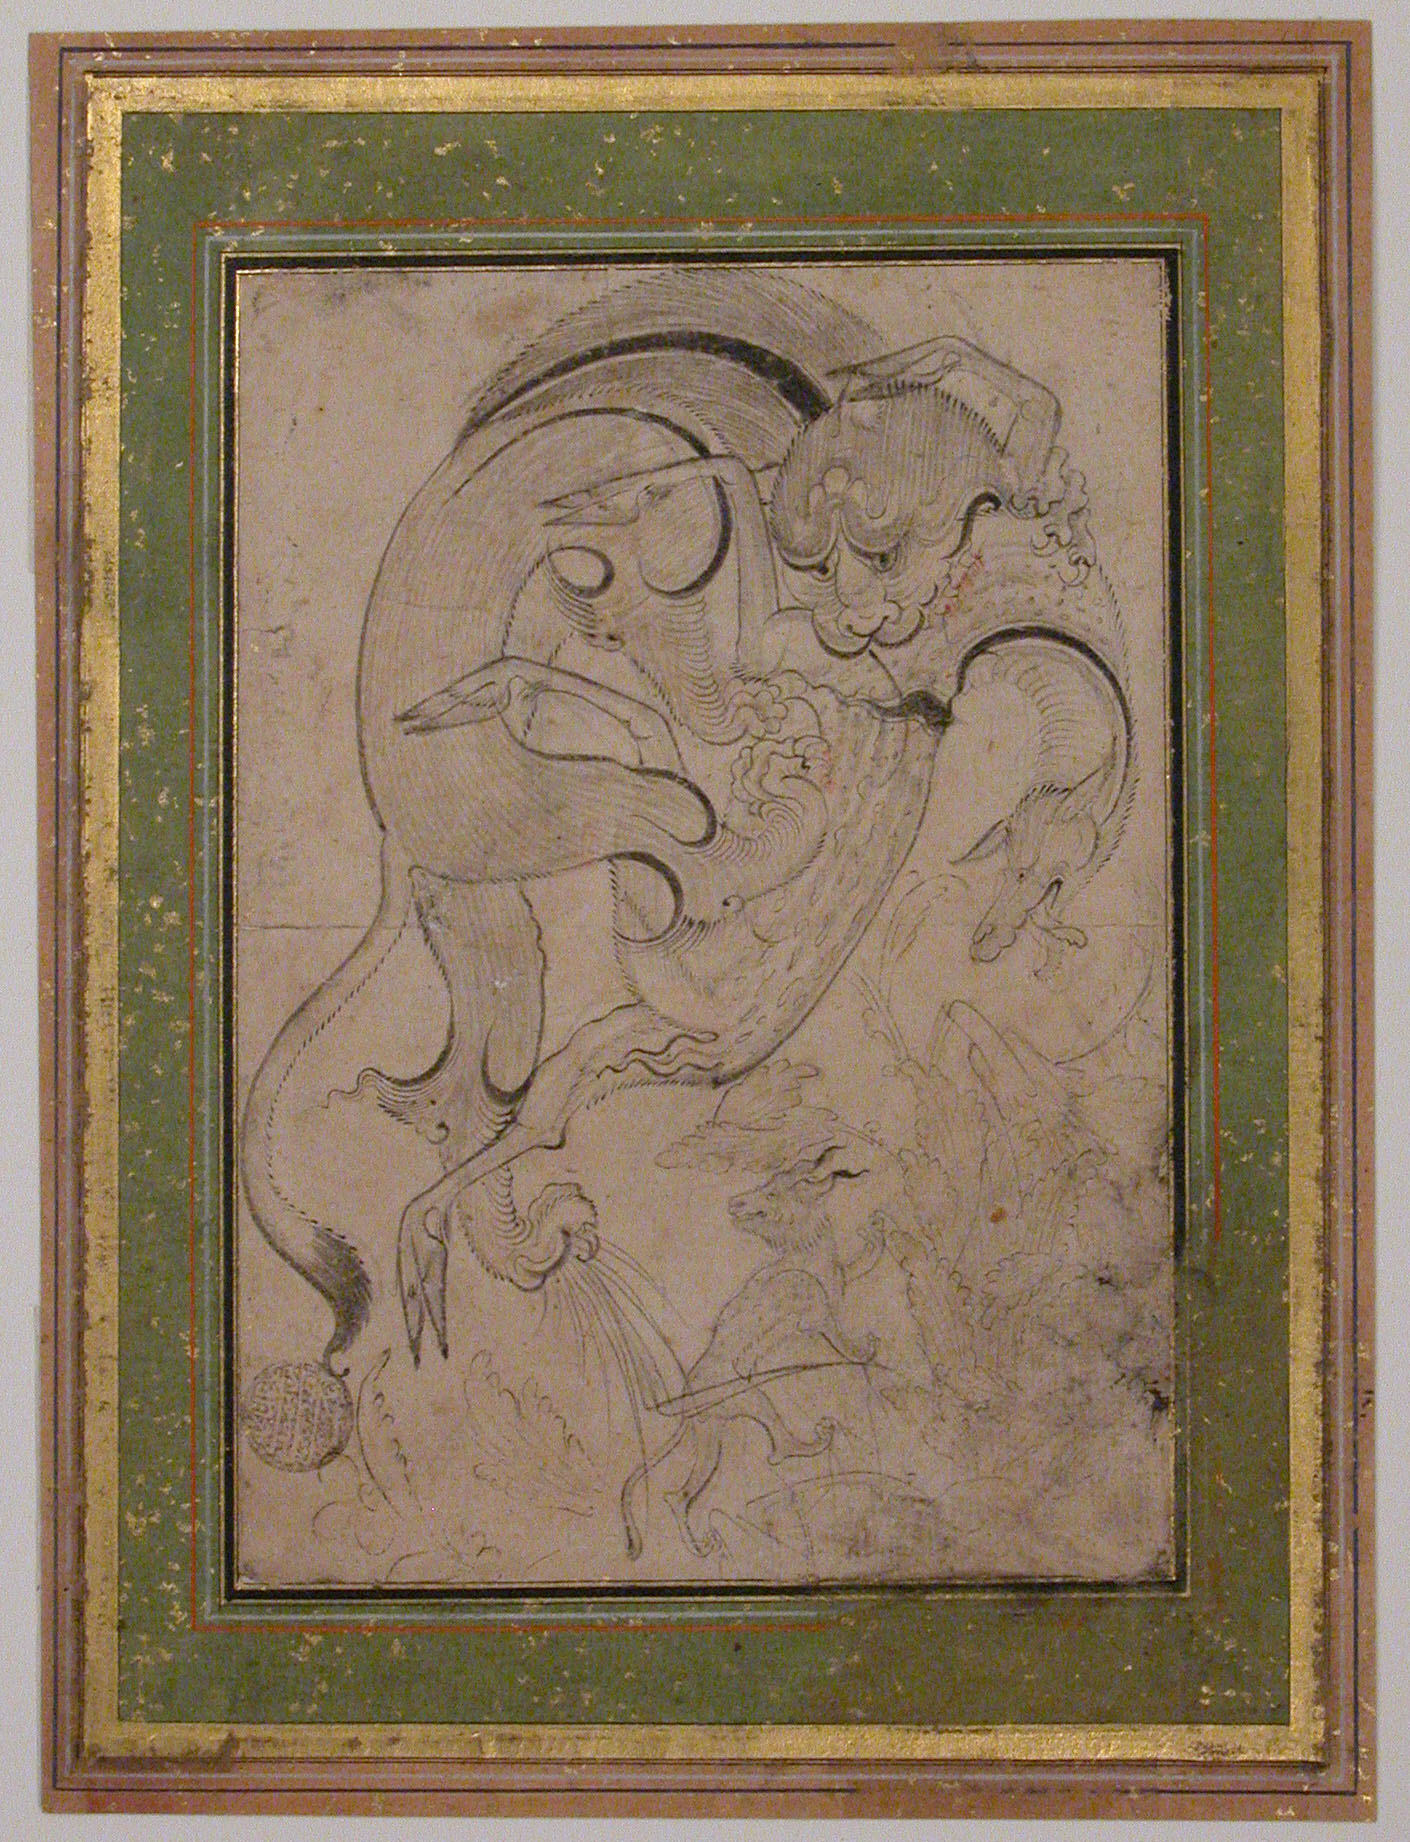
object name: illustrated single work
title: Lion Attacking an Antelope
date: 1551-1600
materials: ink, paper, watercolor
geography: turkey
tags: lions